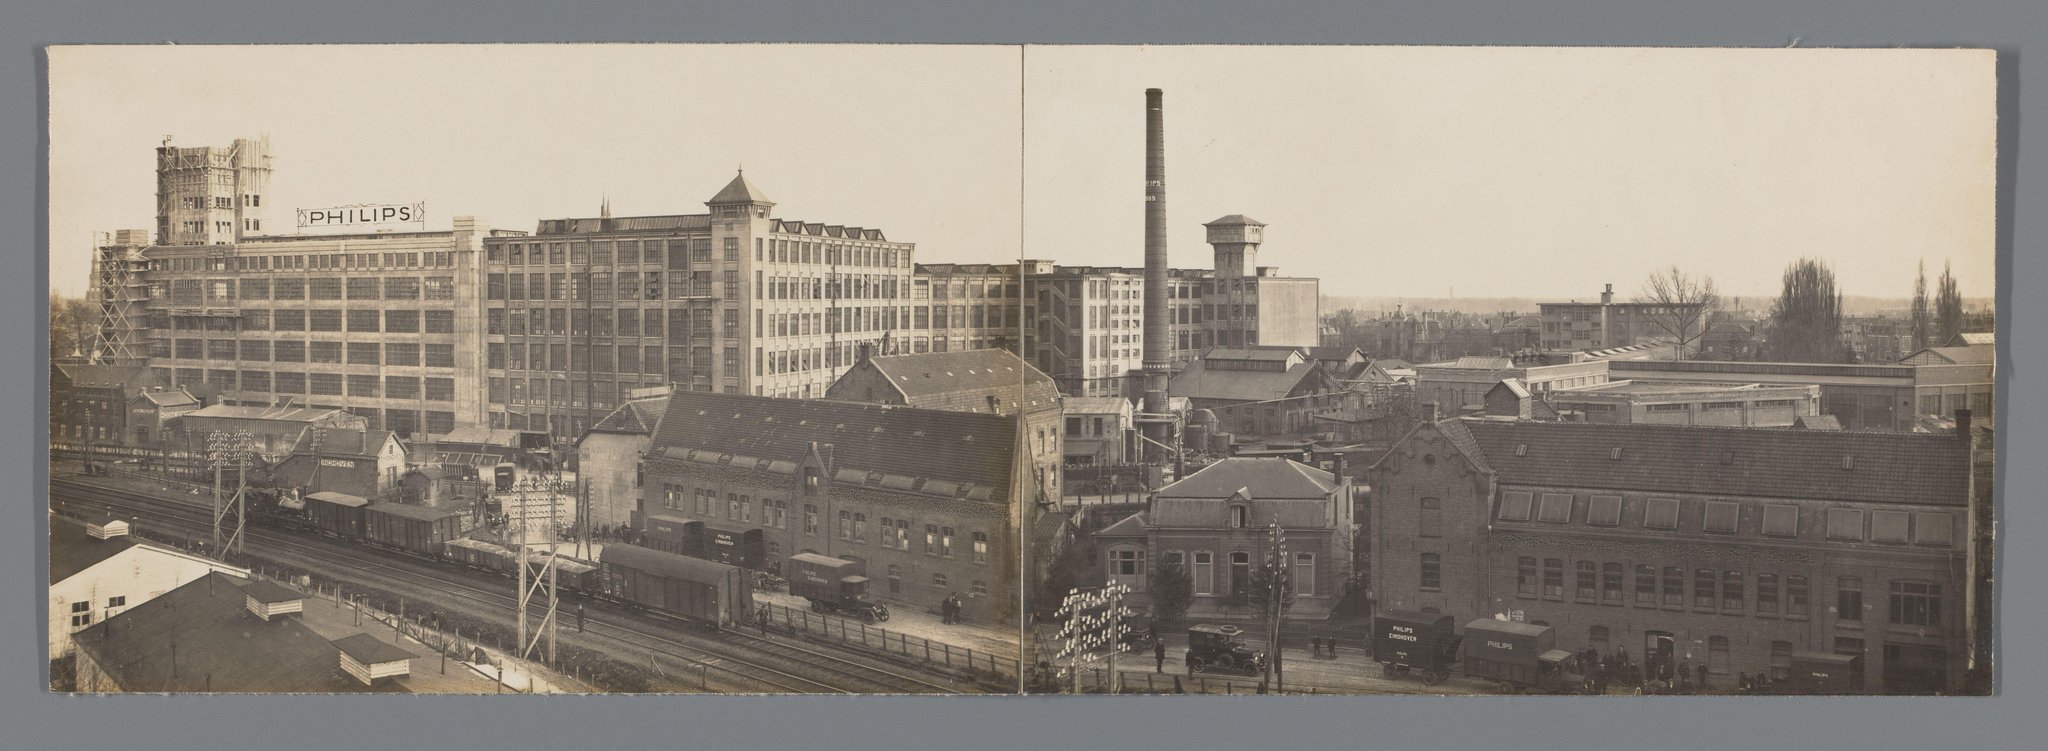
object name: photograph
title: Panorama van de Philips-fabrieken in Eindhoven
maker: maurits herman binger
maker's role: fotograaf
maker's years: 1868-1923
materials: linen, paper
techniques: gelatin silver print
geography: eindhoven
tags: factory-building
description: Panorama van de Philips-fabrieken in Eindhoven met transportwagens en spoorwegemplacement